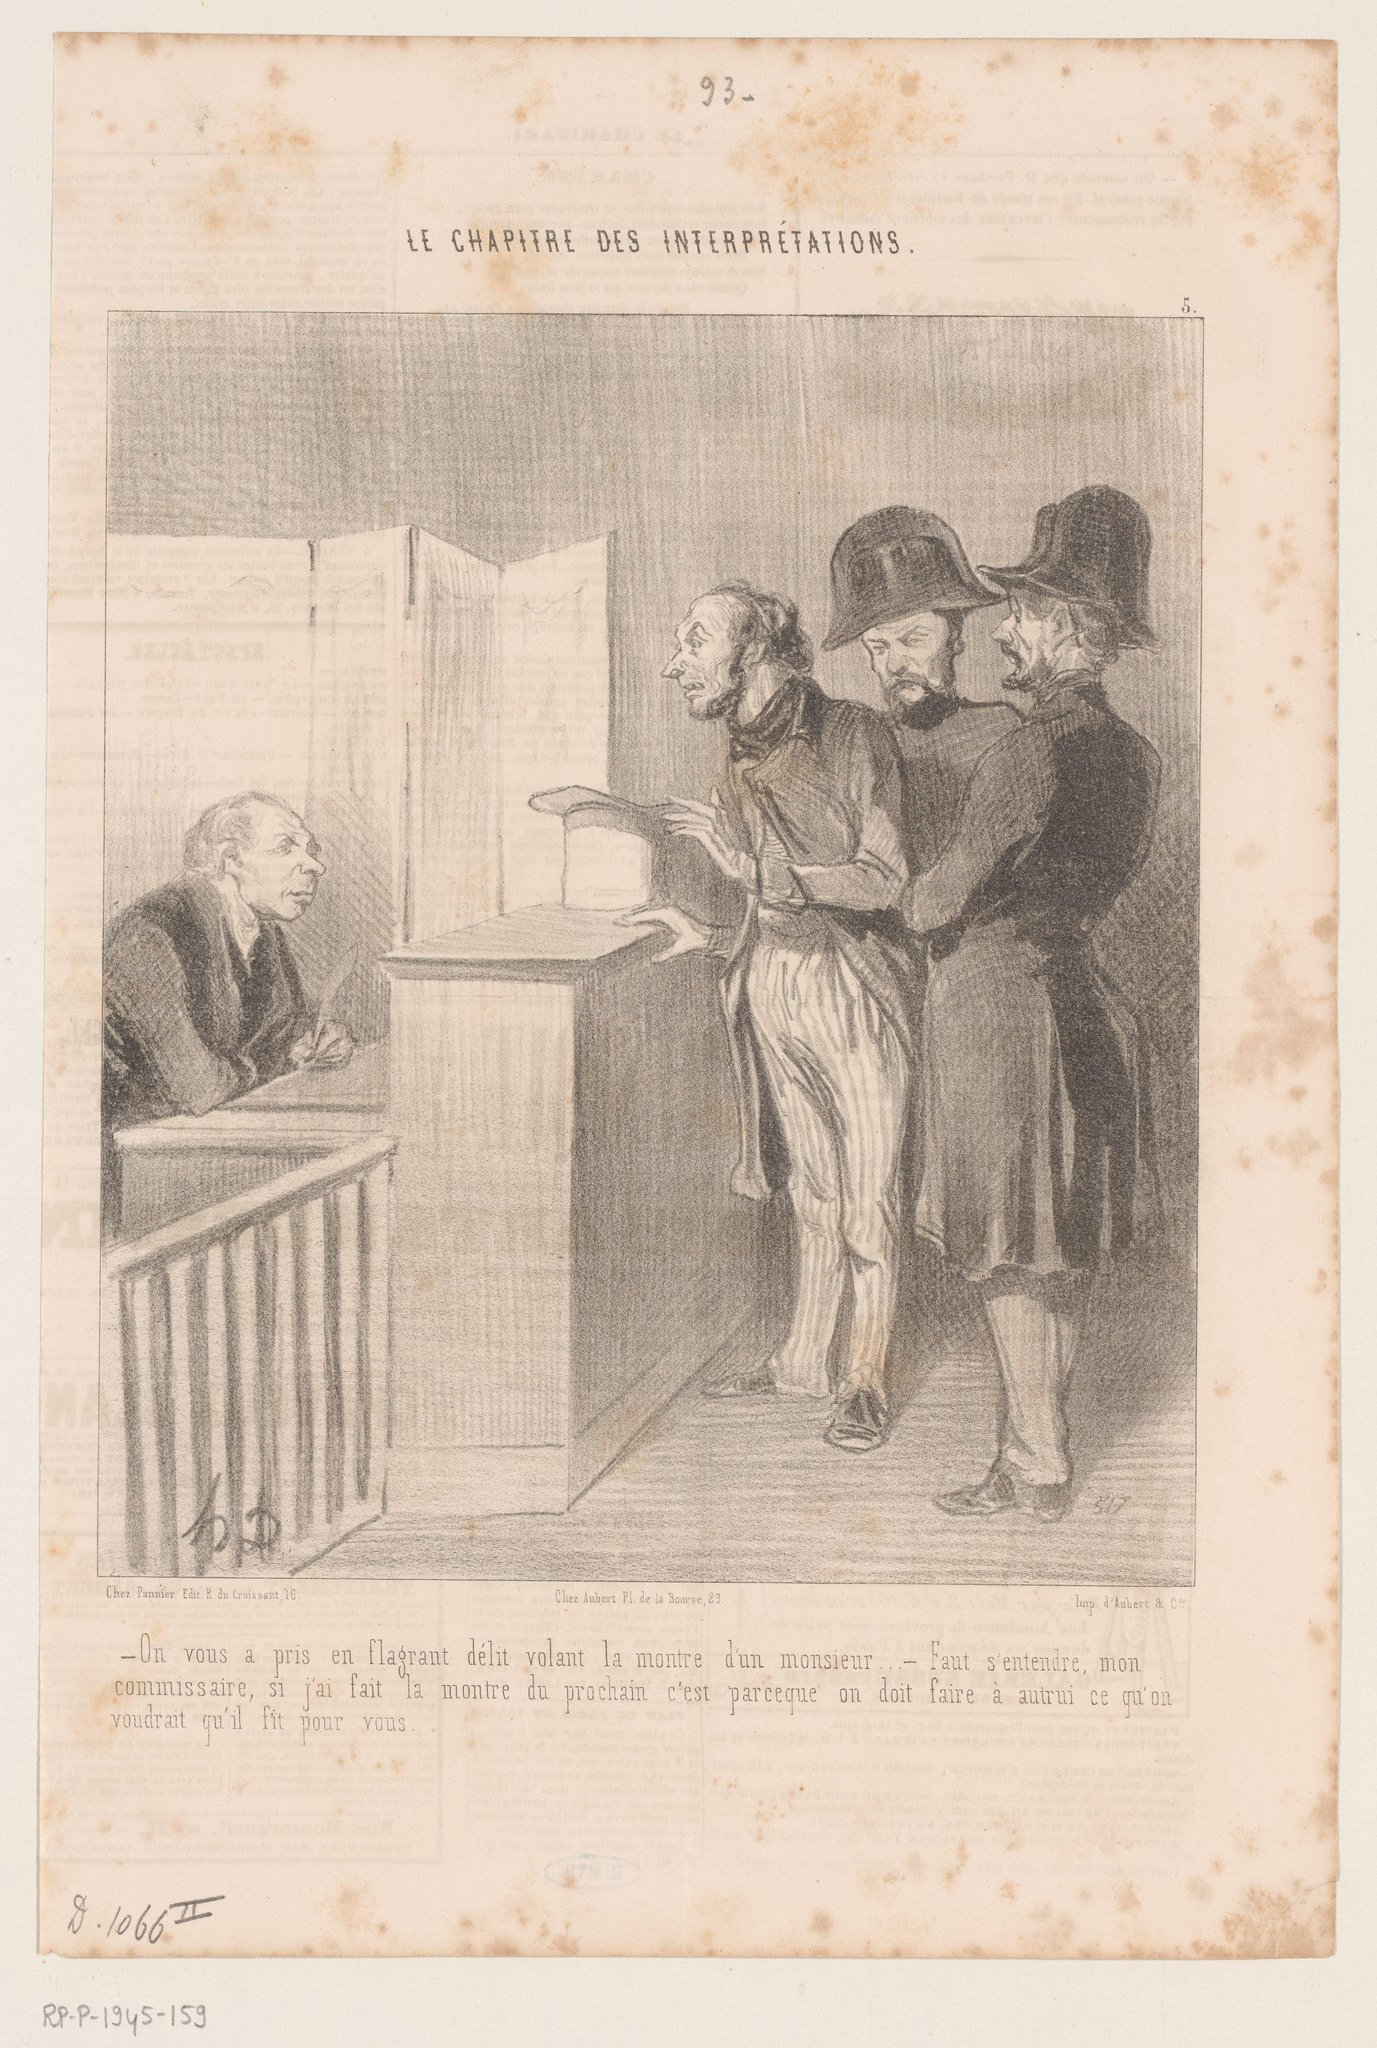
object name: cartoon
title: Man verdedigt zich voor de politie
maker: honoré daumier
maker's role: draughtsman, painter, print maker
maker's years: 1808-1879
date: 1843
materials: paper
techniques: lithograph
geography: paris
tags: caricatures (human types), linguistic communication, policeman, constable, interrogation of arrested person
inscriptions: collector's mark: Lugt 2228a, number: ‘93’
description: Prent gepubliceerd in: Le Charivari, Aubert: Parijs, 22-10-1843. Le Charivari was een humoristische krant met karikaturen en (politieke) cartoons.